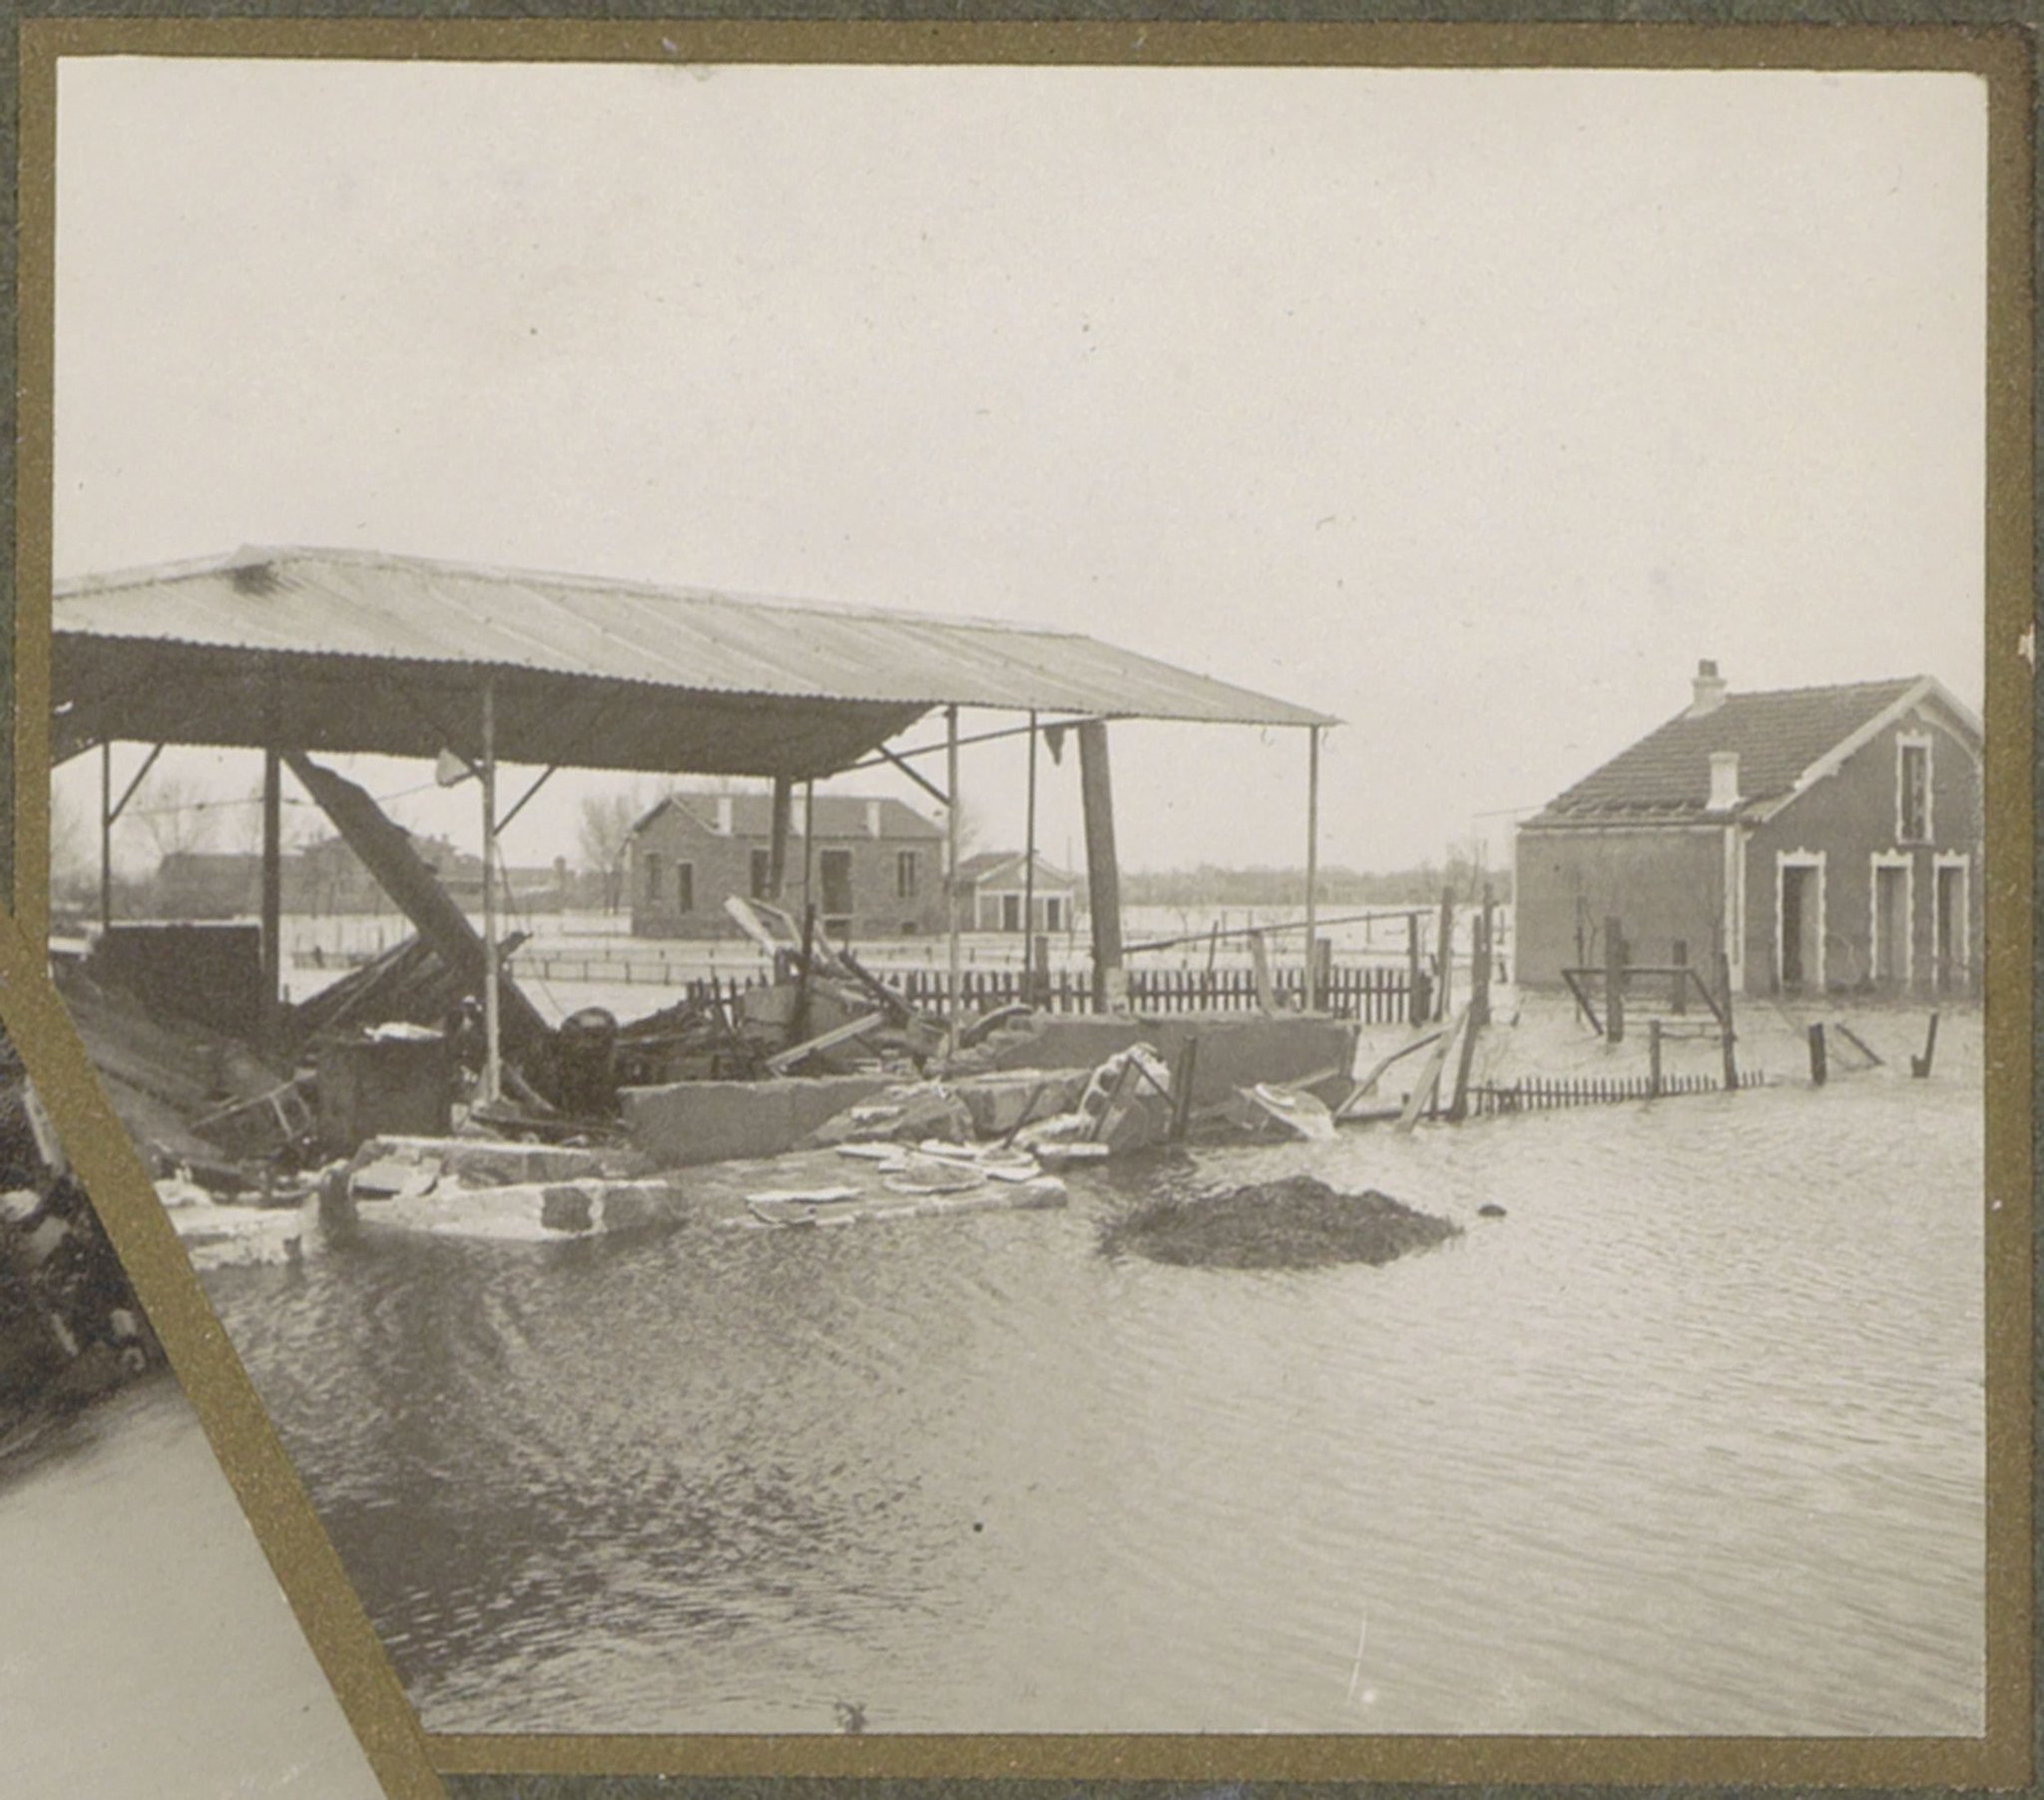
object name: photograph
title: Verwoeste schuur en huis in een ondergelopen buitenwijk van Parijs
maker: g. dangereux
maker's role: fotograaf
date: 1901-1910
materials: photographic support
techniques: matte daylight collodion silver print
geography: paris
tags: barn, flood (+ landscape with figures, staffage), rural housing, e.g. country-house, villa, cottage, paris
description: Onderdeel van fotoalbum overstroming Parijs en voorsteden 1910.